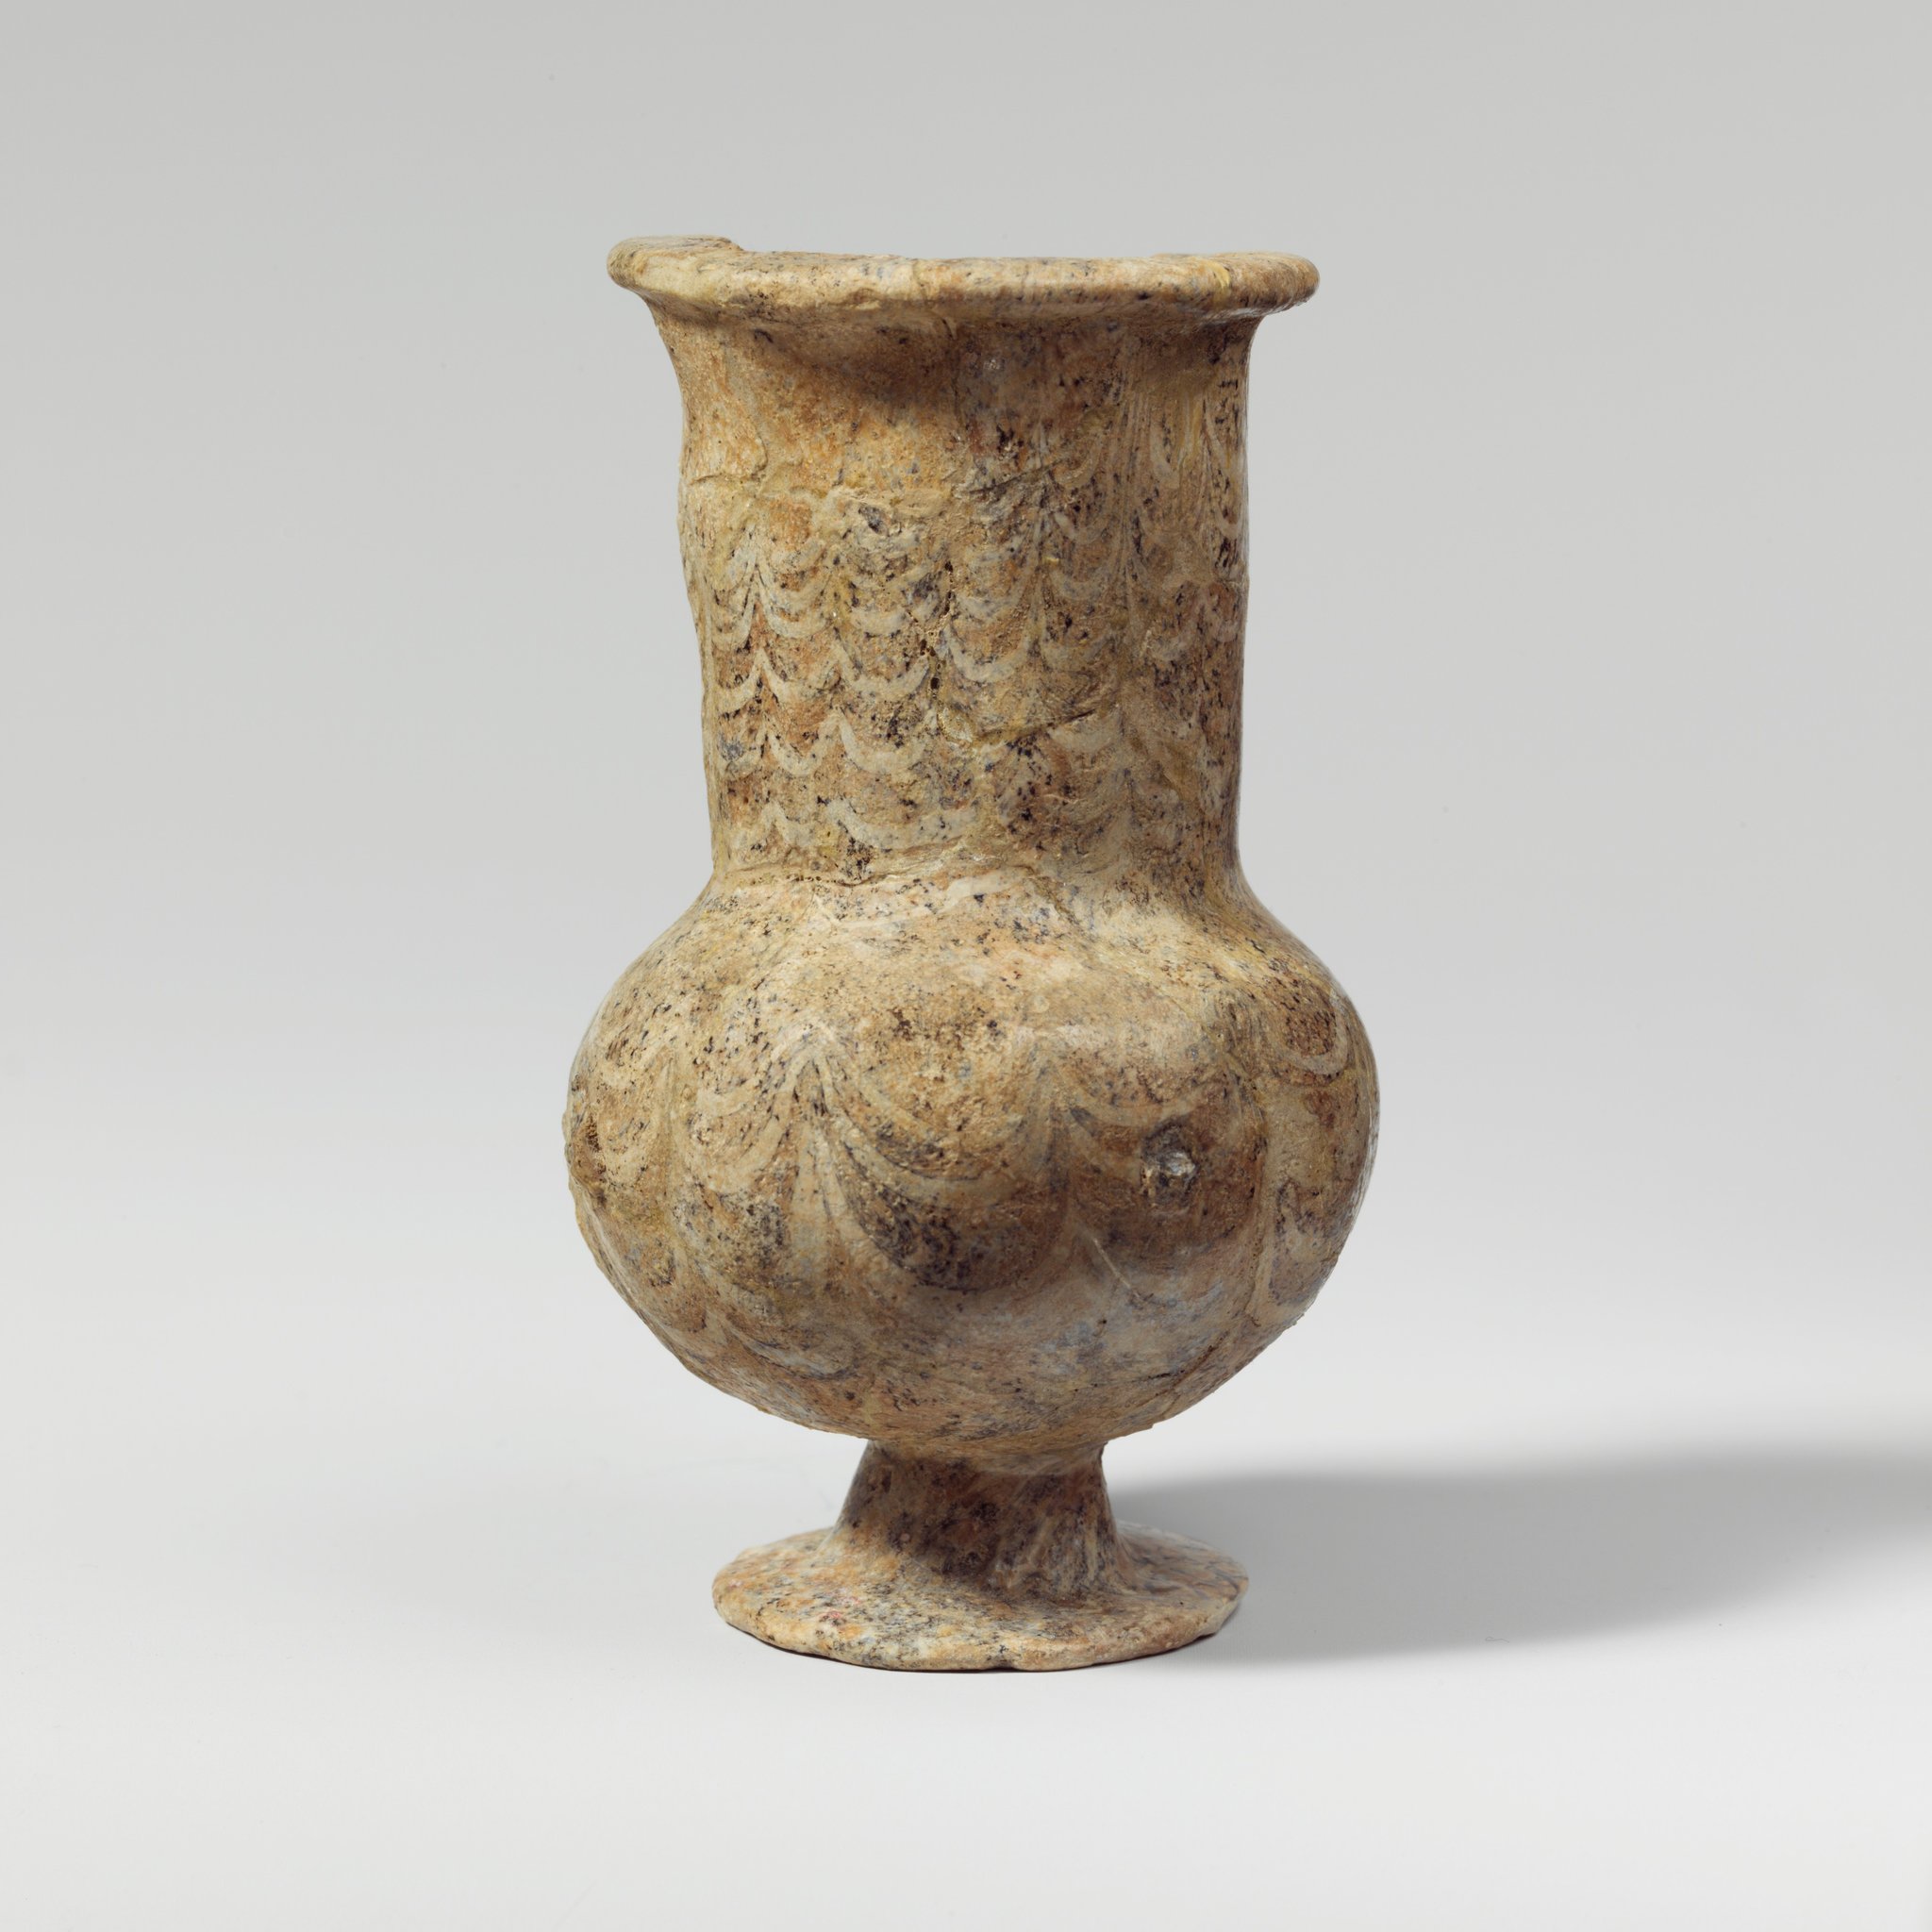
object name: krateriskos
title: Glass krateriskos (unguent jar)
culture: cypriot or egyptian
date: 1400-1350 BCE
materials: glass